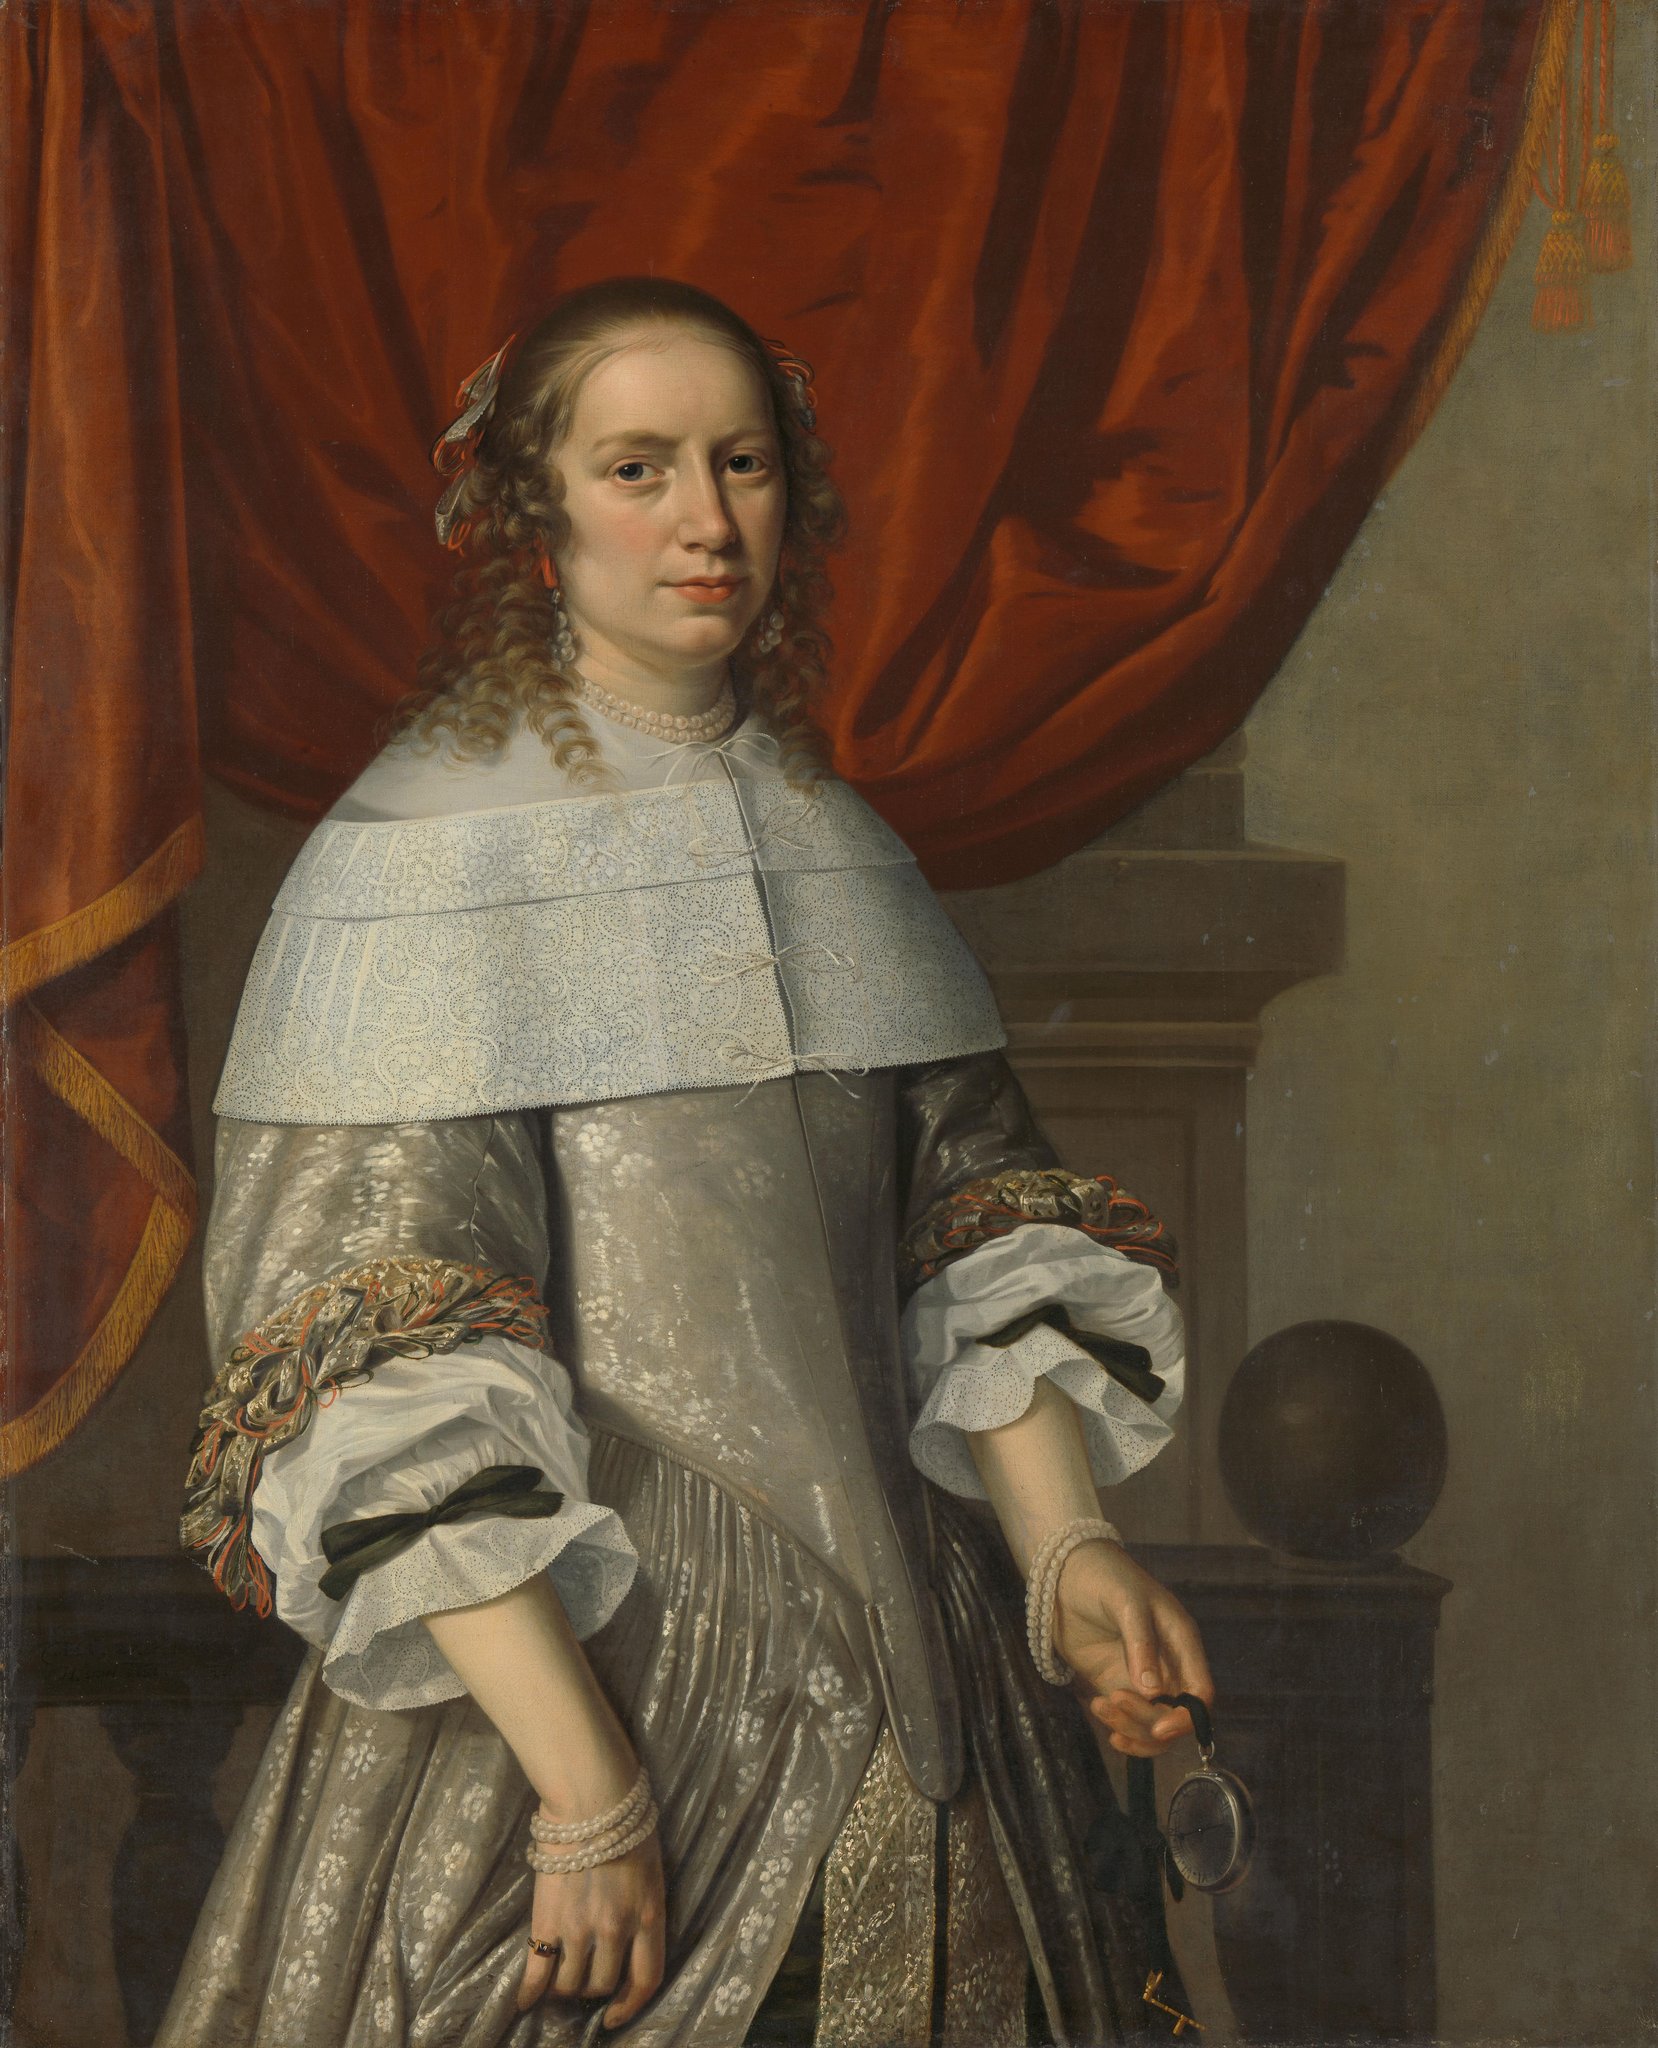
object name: painting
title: Portrait of a 27-Year-Old Woman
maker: hendrick van vliet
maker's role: painter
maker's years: 1611-1675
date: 1663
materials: canvas, oil, paint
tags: historical persons not known by name - bb - woman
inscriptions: signature, date and inscription, lower left, on the balustrade: ‘AETA. 27.Ao. 1663 / H. van. Vliet. 8/28’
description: Portret van een vrouw op 27-jarige leeftijd. Heupstuk, staande voor een balustrade, in de rechterhand een horloge aan een lint.